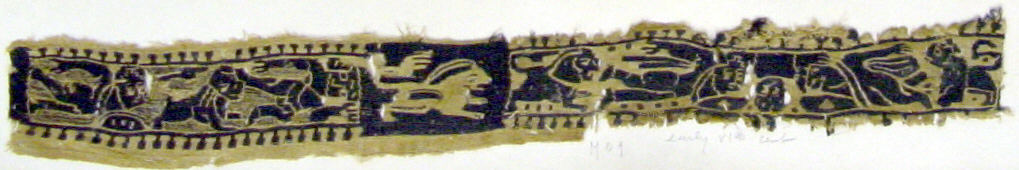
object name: textile fragment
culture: coptic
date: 401-500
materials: linen, wool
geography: egypt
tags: animals